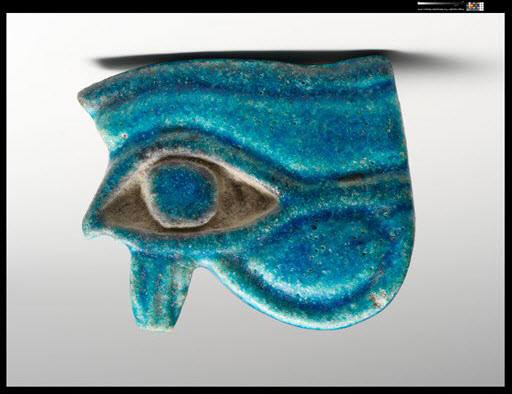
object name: amulet, eye, udjat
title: Faience Udjat eye amulet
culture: egyptian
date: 1-100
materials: faience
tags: eyes